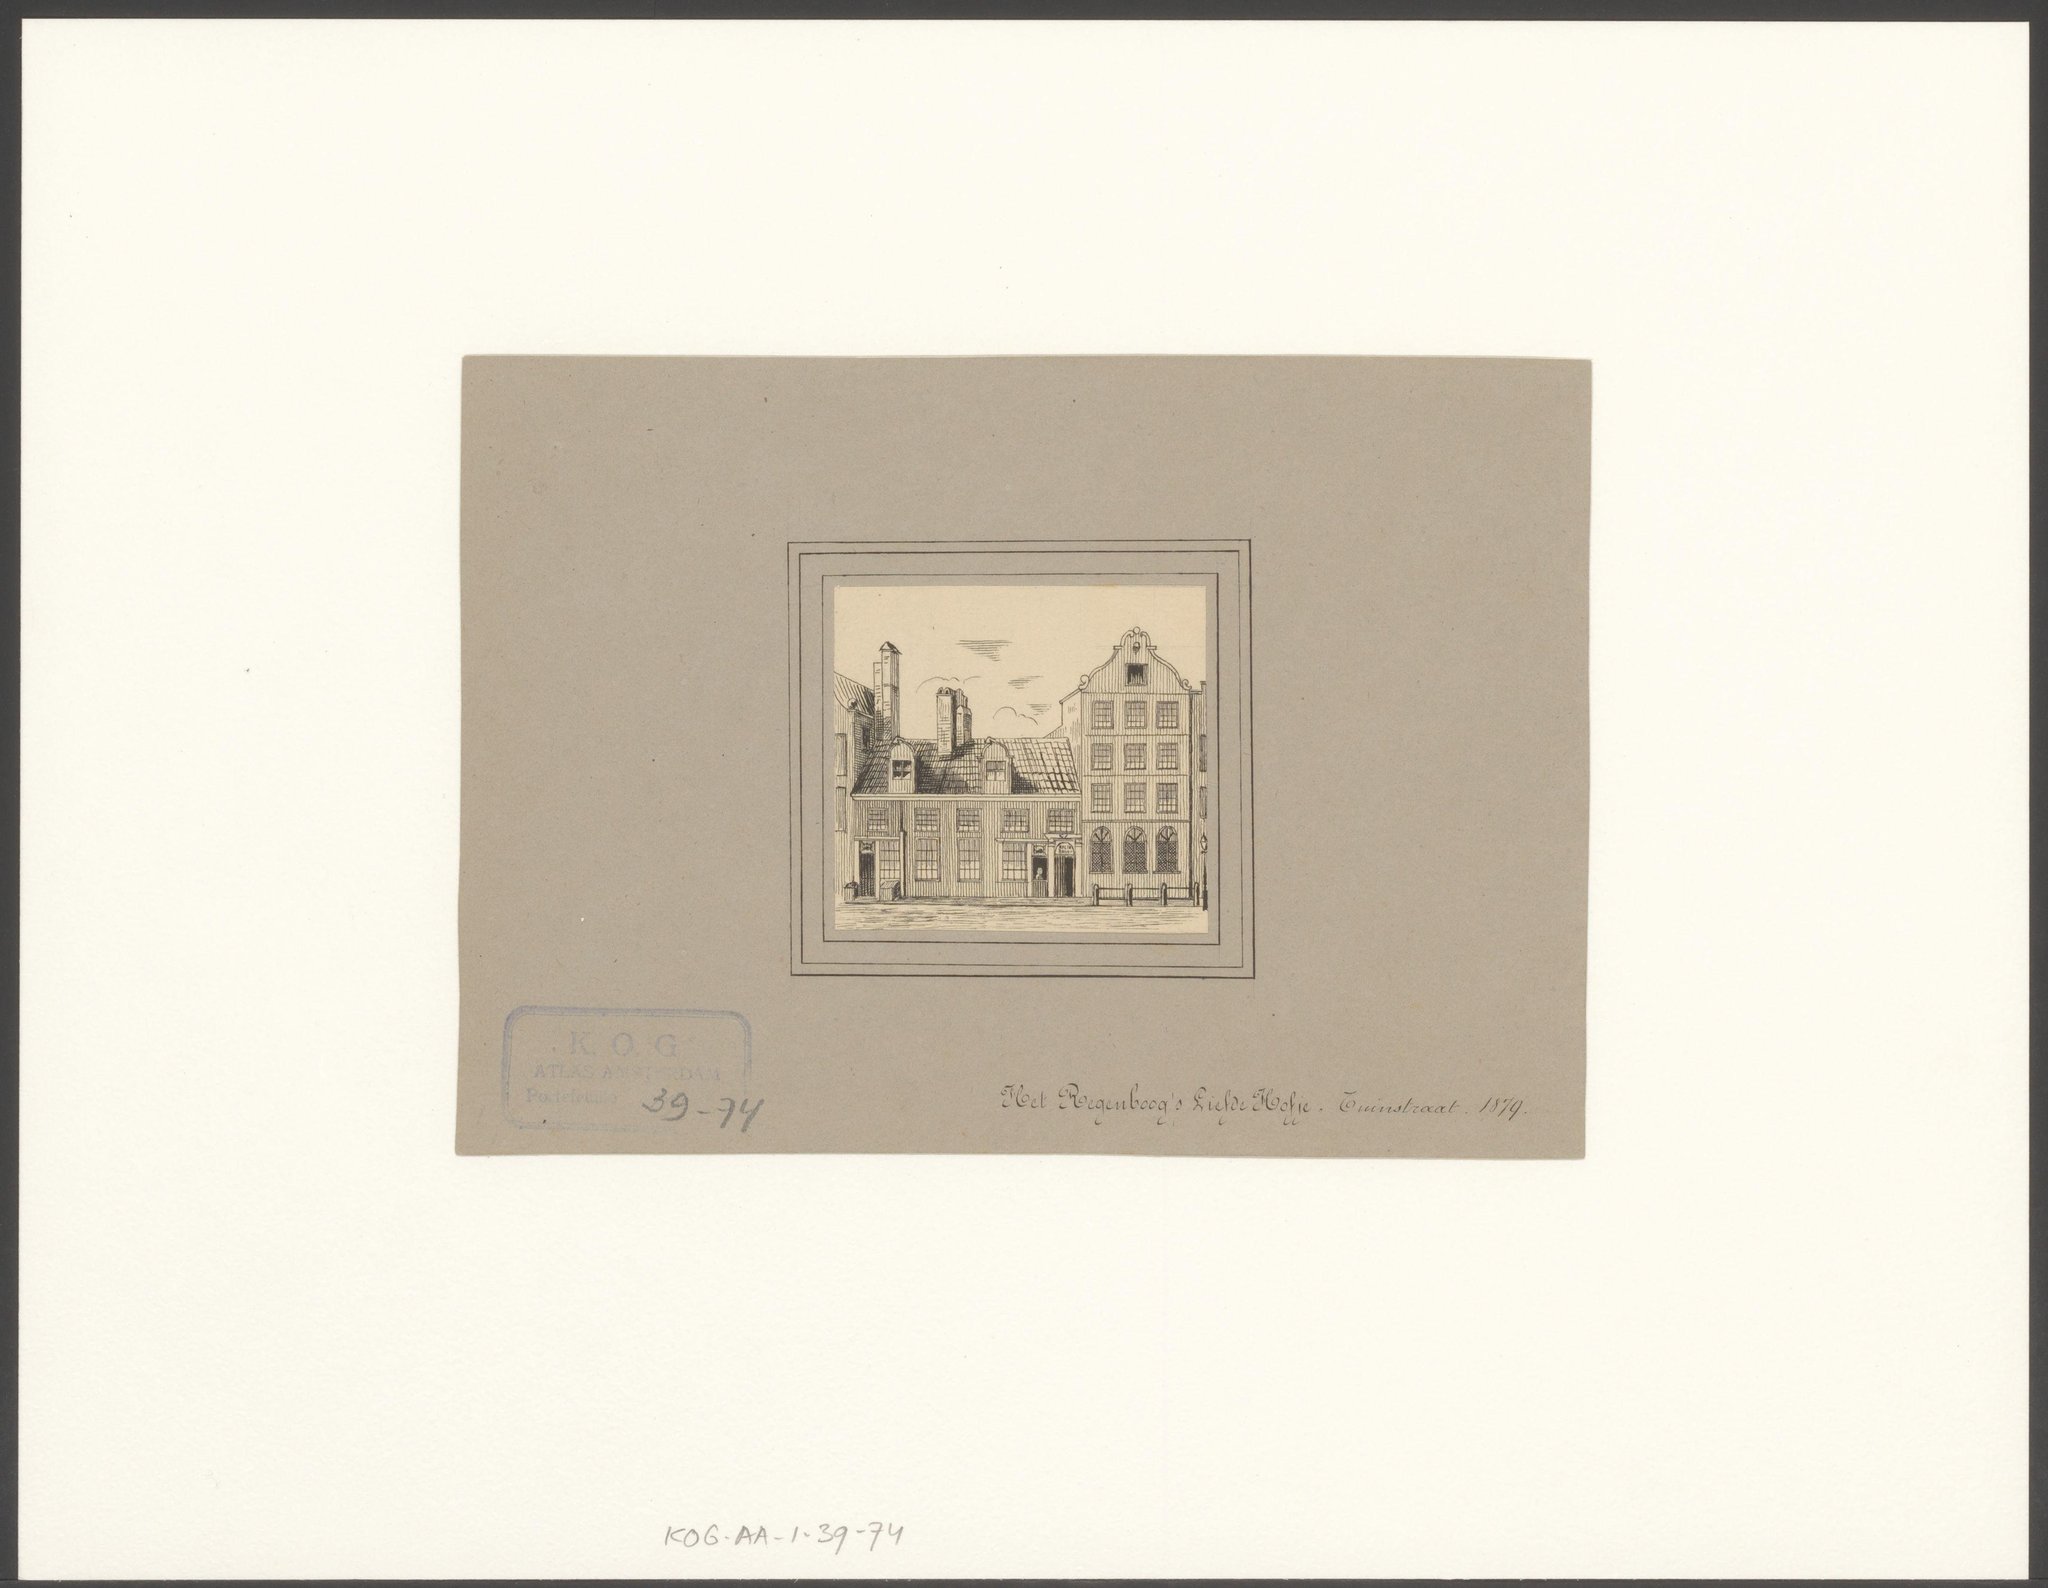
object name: drawing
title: Gezicht op het Regenboogs-Liefdehofje te Amsterdam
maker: Anonymous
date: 1879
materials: ink, paper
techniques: pen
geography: amsterdam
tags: alms-house (dutch: 'hofje'), street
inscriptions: collector's mark: Lugt 1641b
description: Onderwerpsrubriek binnen de Atlas Amsterdam: Armwezen en liefdadige instellingen: III. Verschillende gestichten en instellingen / Hofjes: Rapen- en Bosscherhofje - Regenboog's liefde Hofje - Rijper-Hofje.